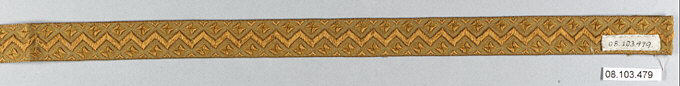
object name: galloon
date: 1801-1900